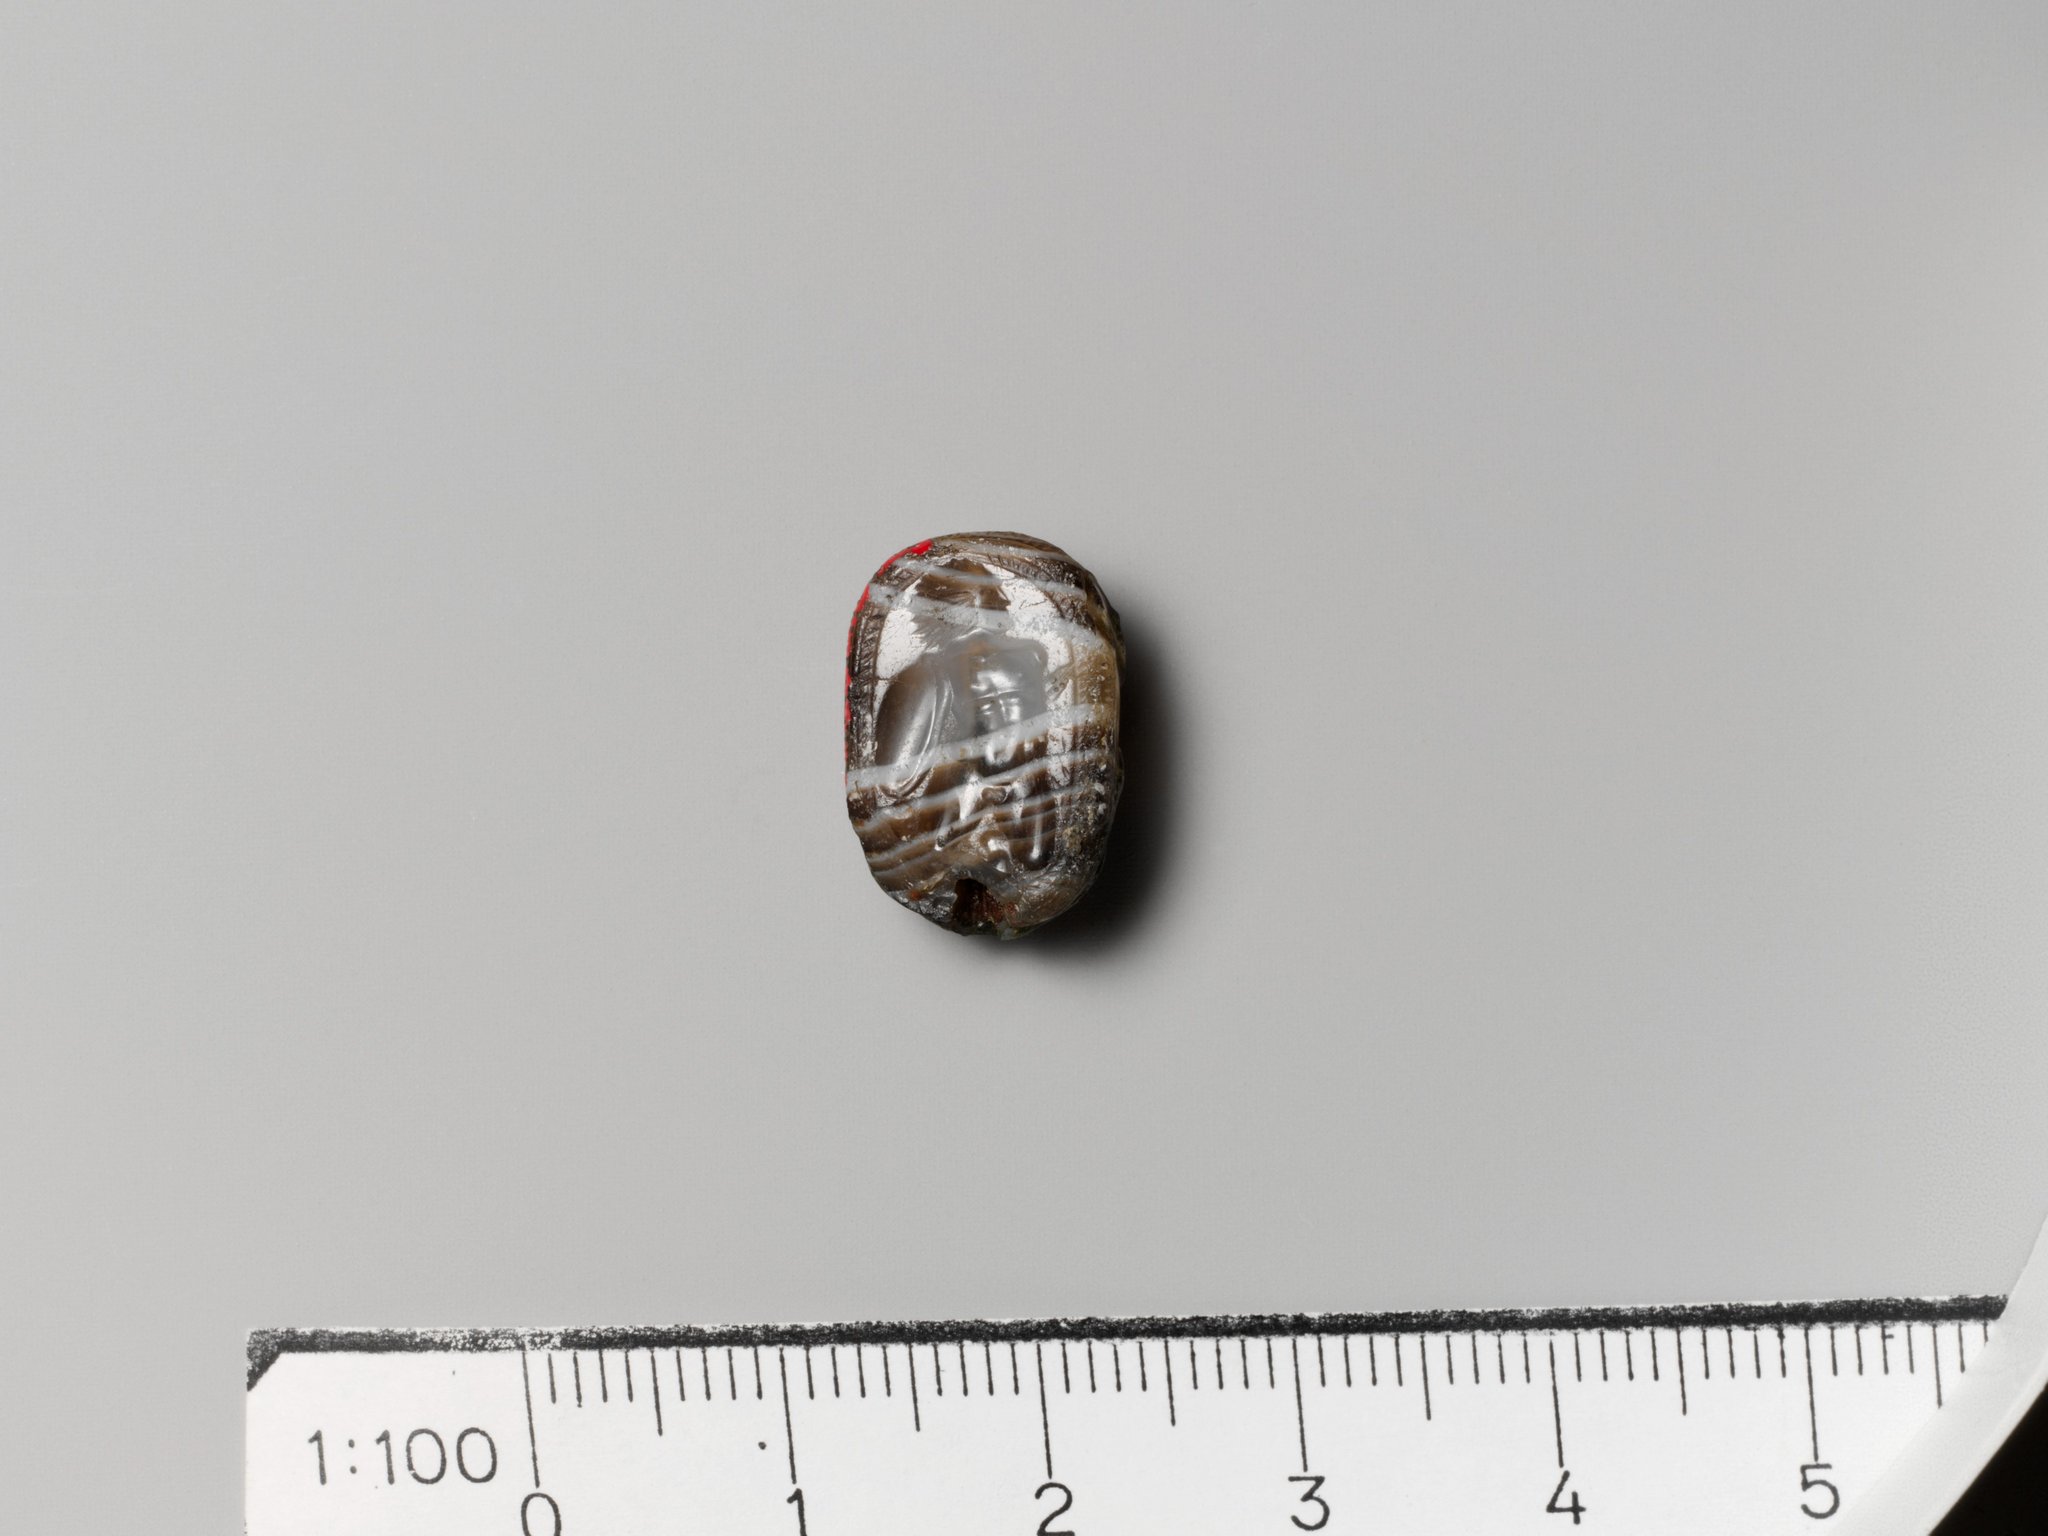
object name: scarab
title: Agate scarab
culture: etruscan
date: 500-301 BCE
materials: stone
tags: shields,male nudes